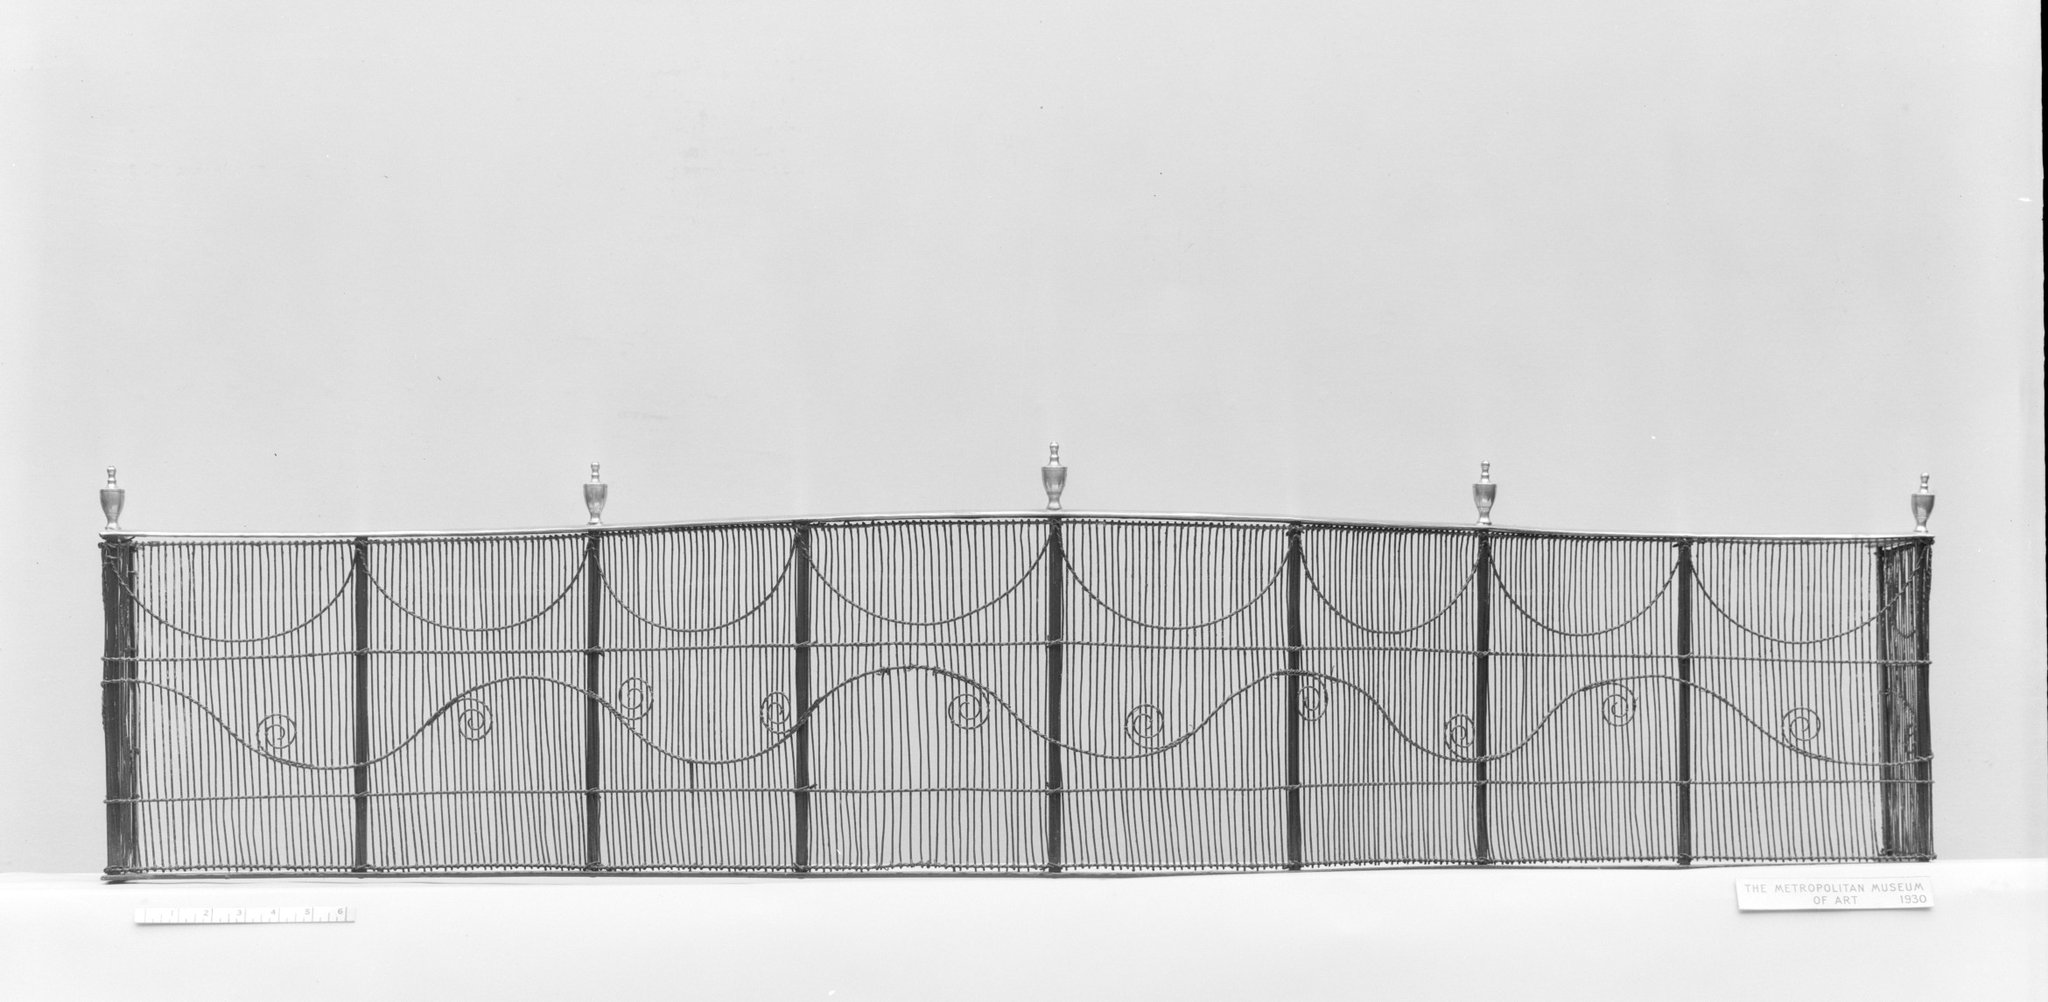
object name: fender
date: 1700-1800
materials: brass, iron